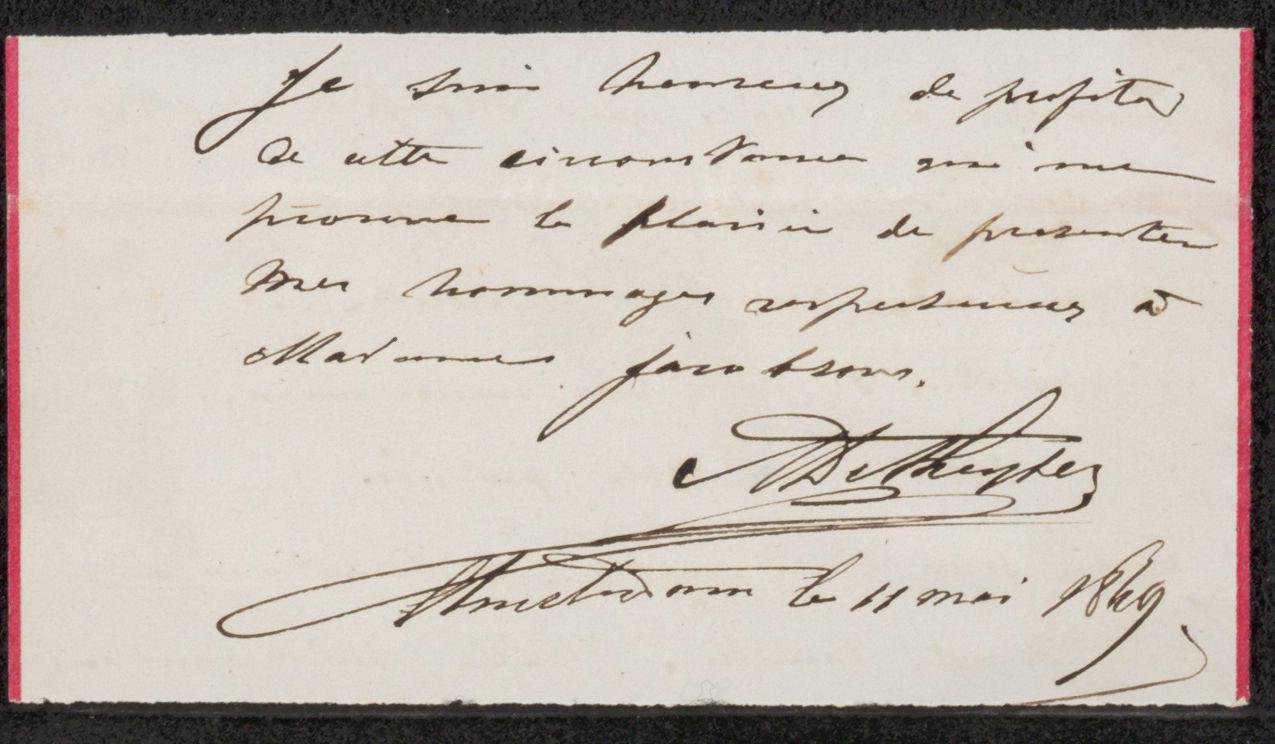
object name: letter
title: Brief aan anoniem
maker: nicaise de keyser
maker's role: draughtsman, painter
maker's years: 1813-1887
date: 1849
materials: ink, paper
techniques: pen, writing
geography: amsterdam